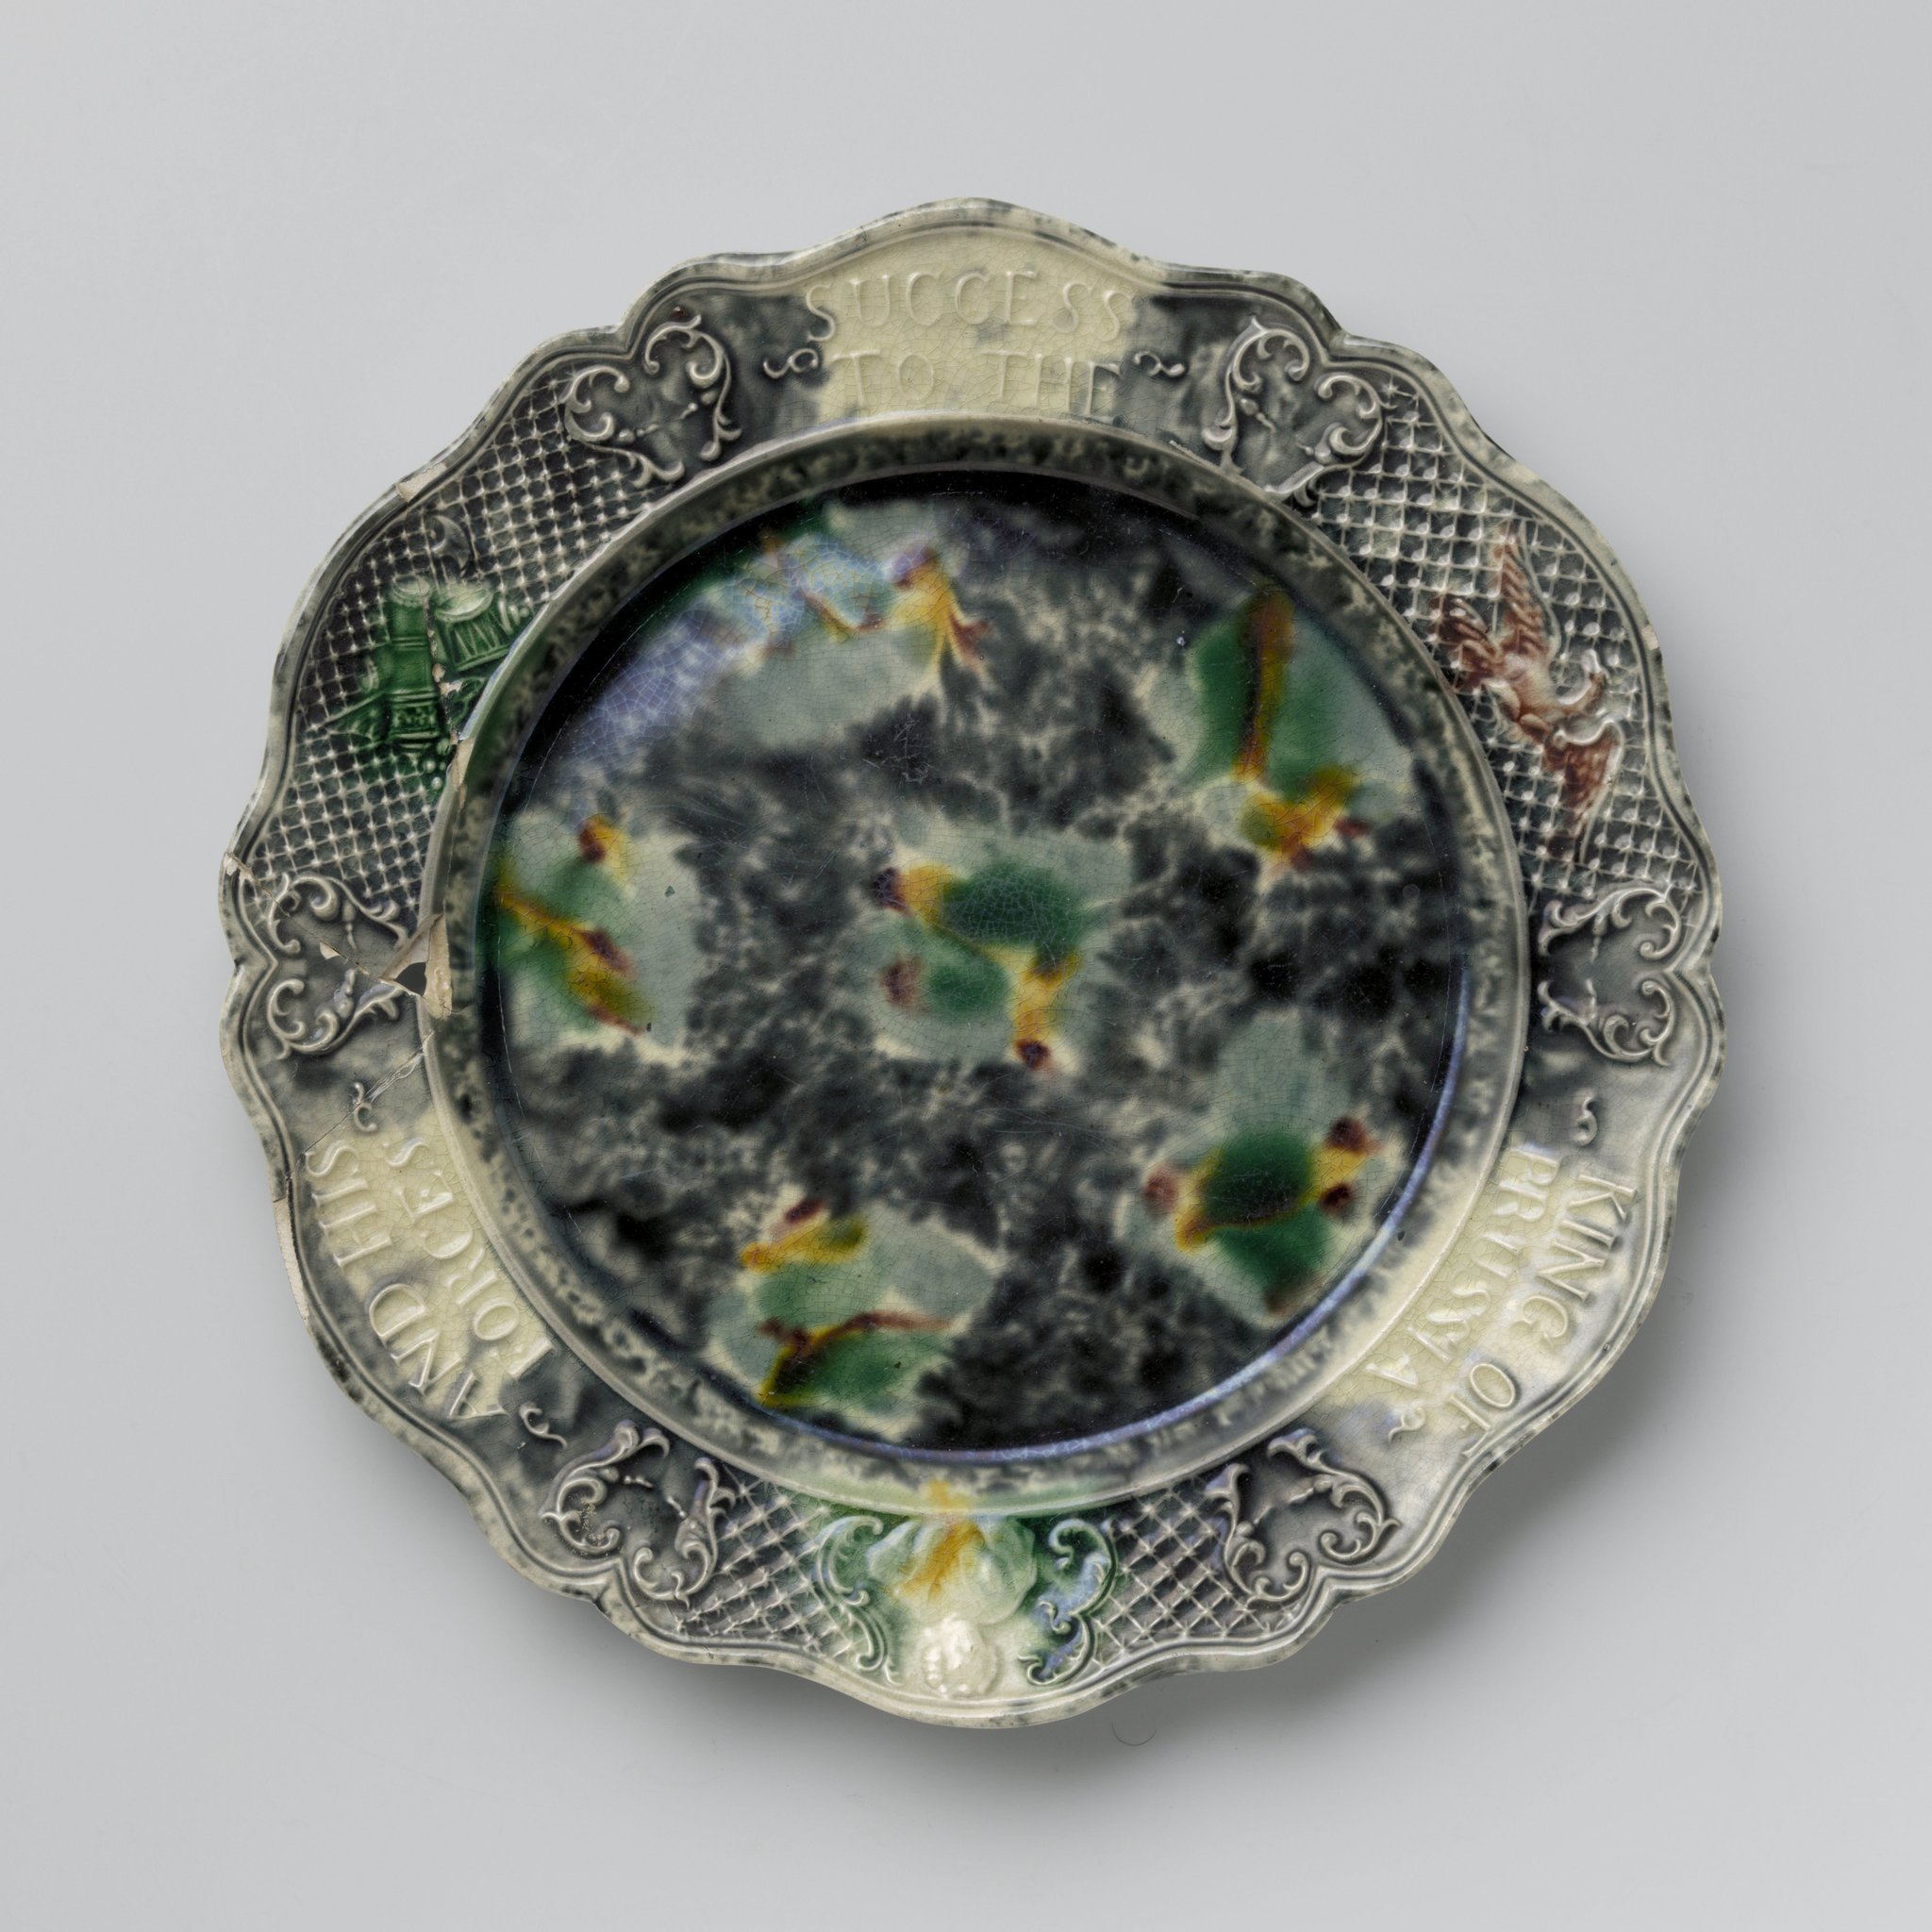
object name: plate dish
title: Rond bord van hardgebakken aardewerk; Staffordshire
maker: Anonymous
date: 1756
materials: earthenware, glaze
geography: england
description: Rond bord van hardgebakken aardewerk, bedekt met blauw-zwarte loodglazuur met vlekken in lichttblauw, groen, geelbruin en mangaan. De rand is in reliëf versierd met velden afwisselend glad en gevuld met traliewerk. Op de tralievelden afwisselend een adelaar, een trofee en het portret van Frederik de Grote. Op de gladde velden de opschriften SUCCES TO THE KING, KING OF PRUSSIA, AND HIS FORCES. Het bord hoort bij vijf borden (BK-1987-40-A t/m BK-1987-40-F).